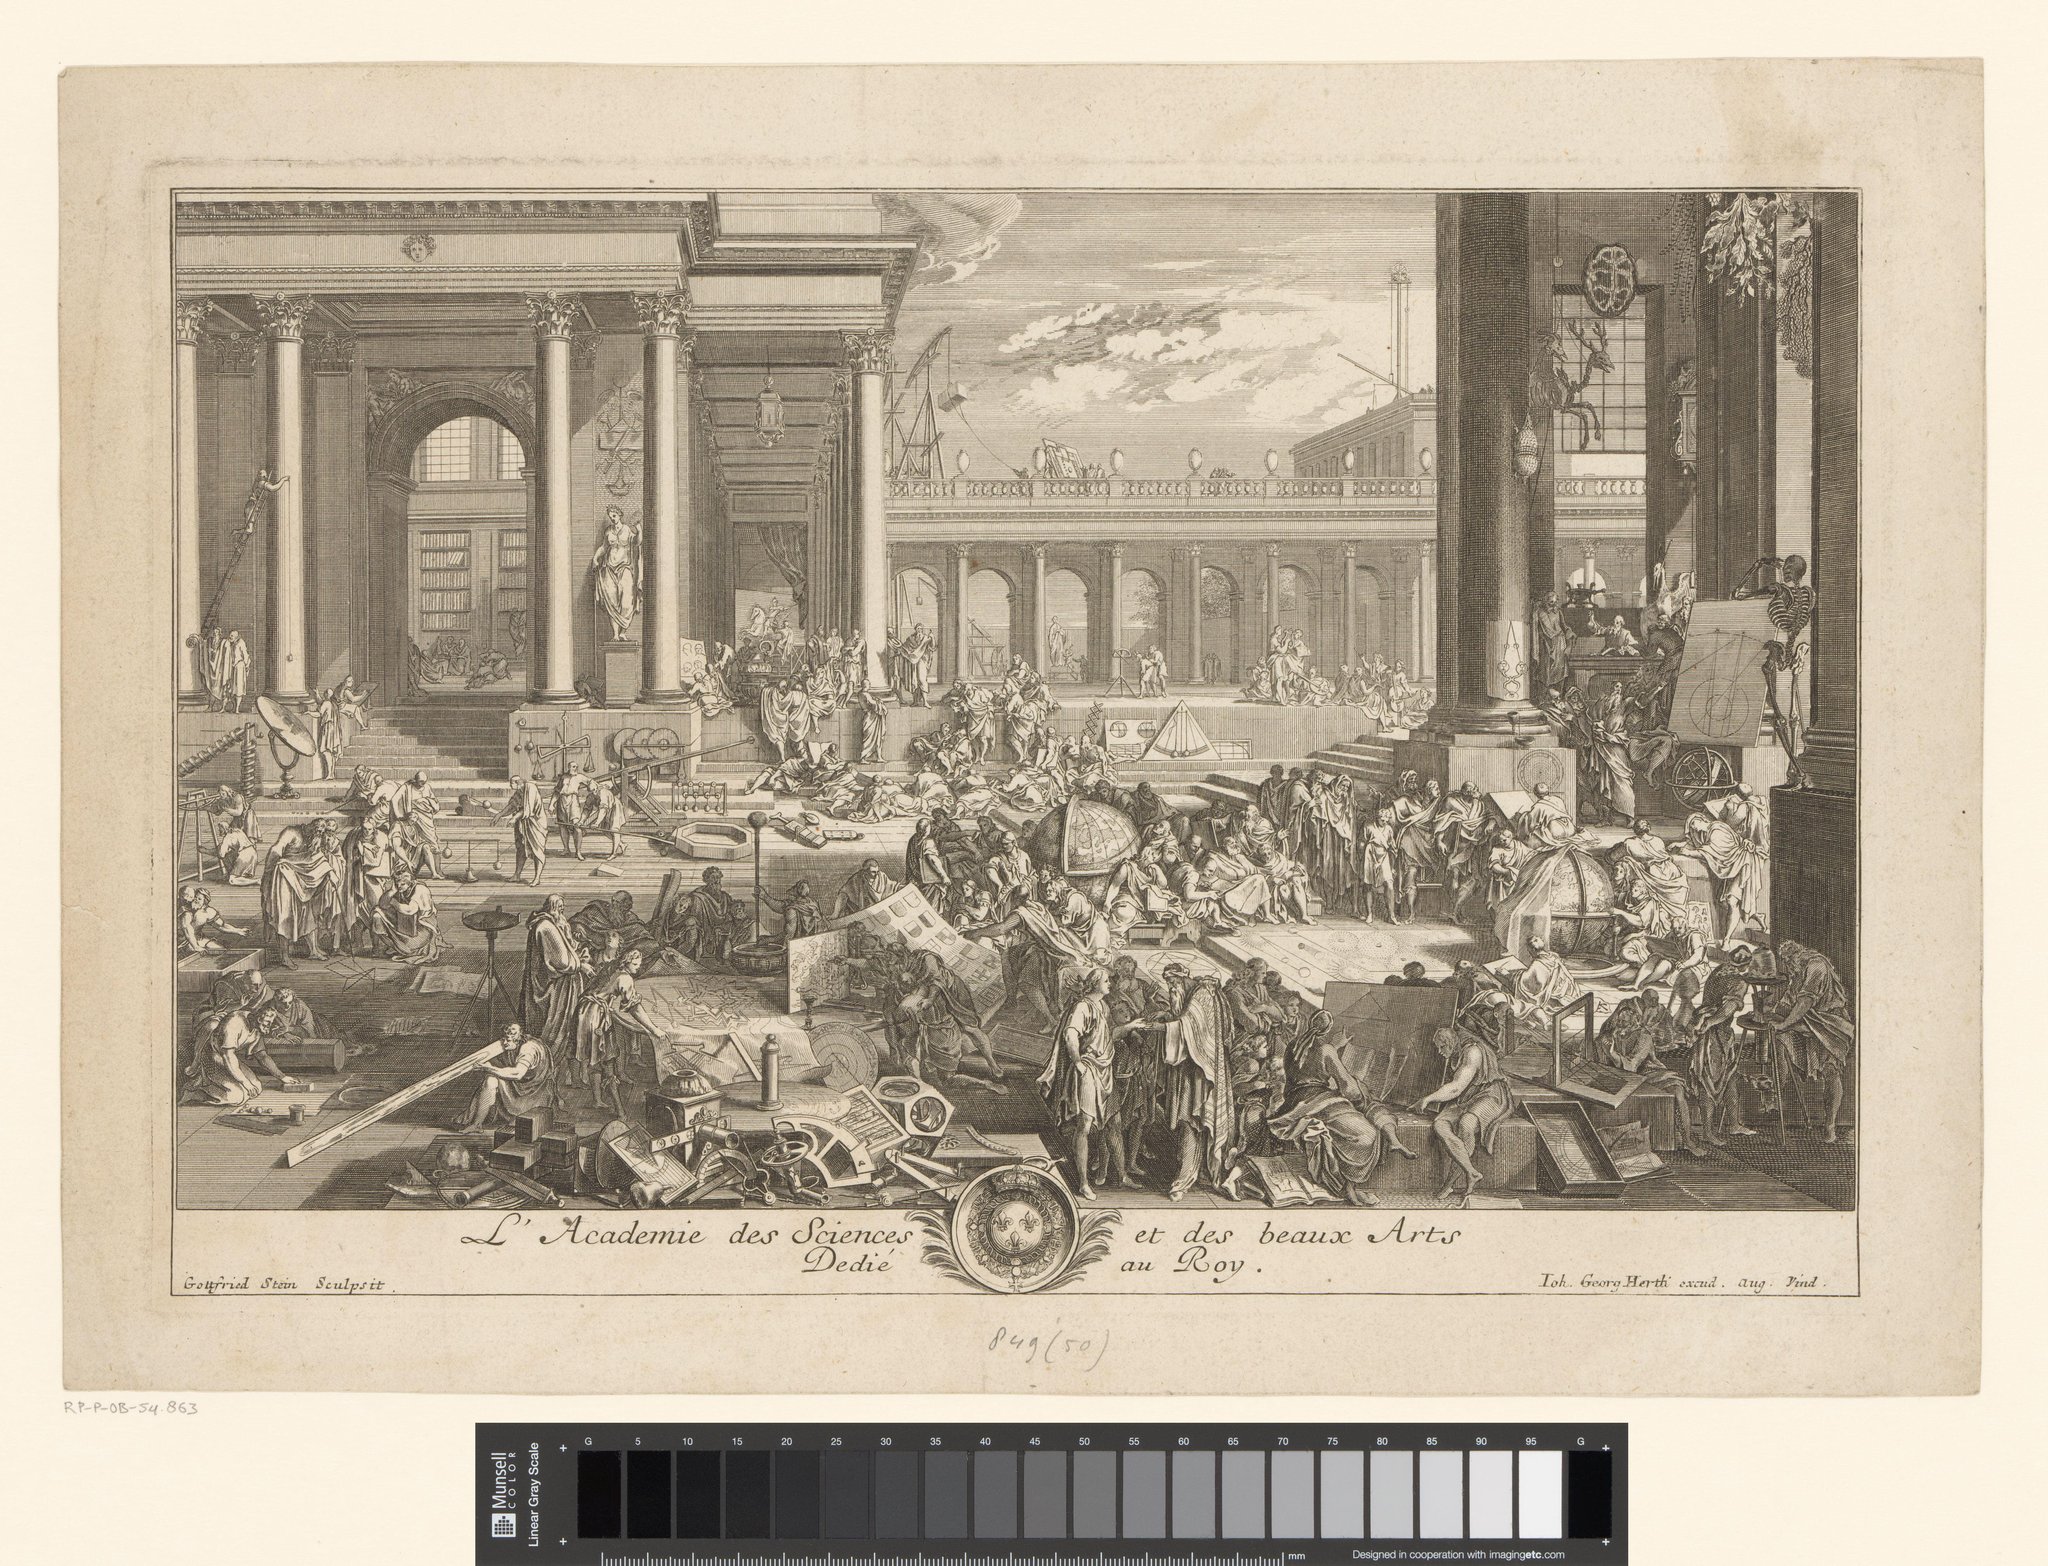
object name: print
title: Academie van wetenschappen en schone kunsten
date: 1710-1775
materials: paper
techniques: engraving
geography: france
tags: academy, association of artists, place or institution of education and training of the artist, e.g.: academy of art, armorial bearing, heraldry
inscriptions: collector's mark: Lugt 2228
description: Allegorie op de Academie van kunsten en wetenschappen met beoefenaren van tal van disciplines, waaronder de schilderkunst, beeldhouwkunst, architectuur, vestingbouw en wiskunde.